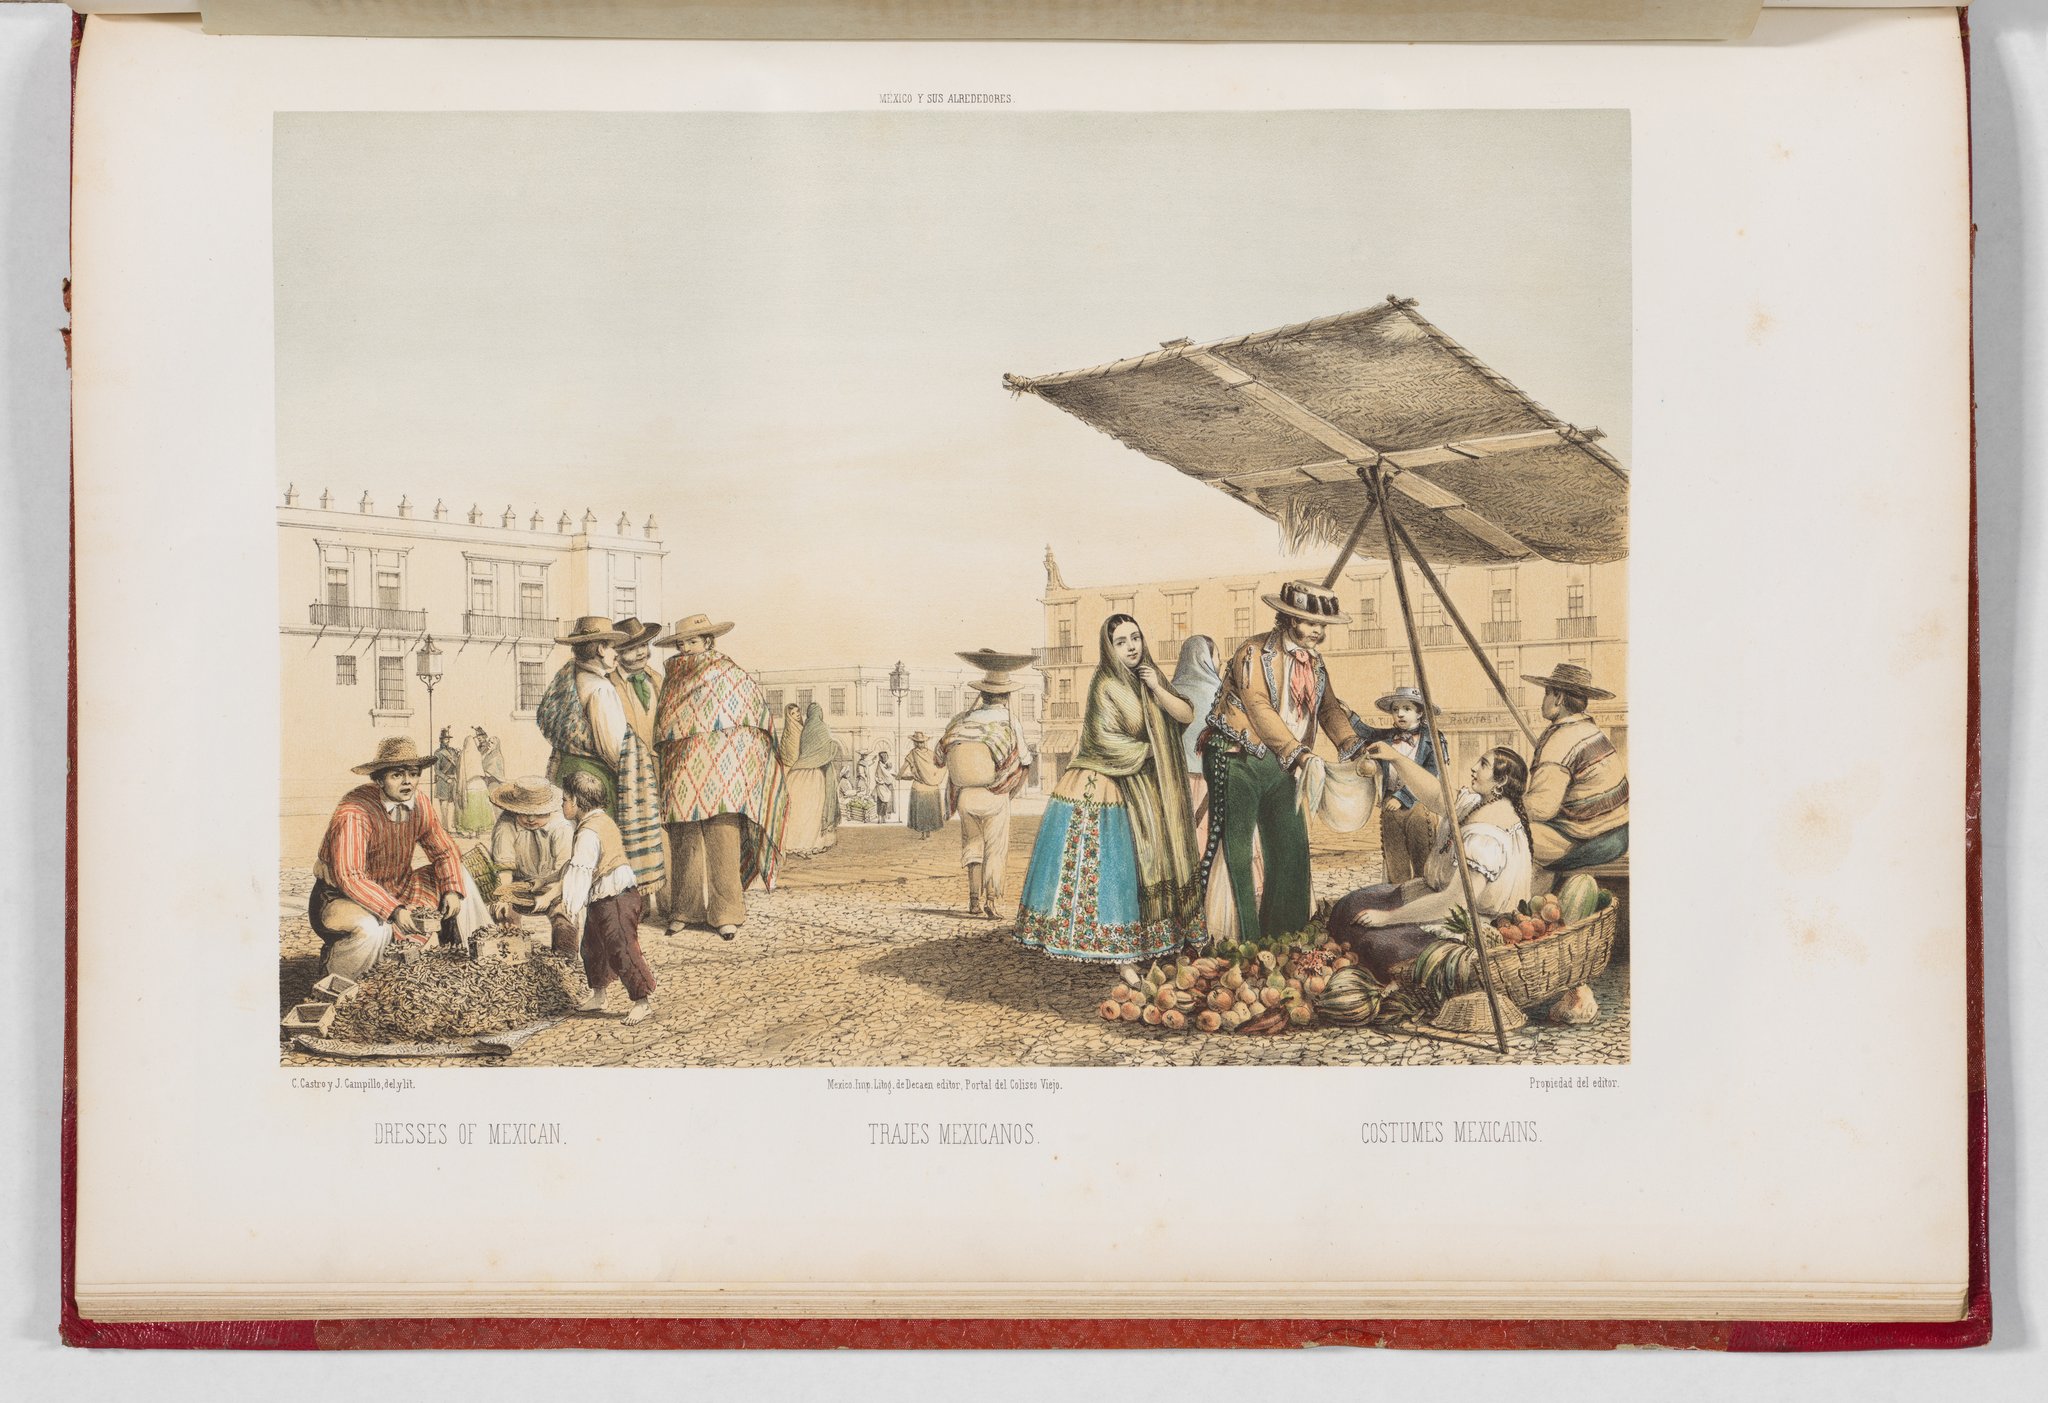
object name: book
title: Mexico y sus Alrededores. Colección de monumentos, trajes y paisajes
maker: casimiro castro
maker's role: artist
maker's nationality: mexican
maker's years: 1826-1889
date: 1855-1856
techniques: letterpress, lithograph